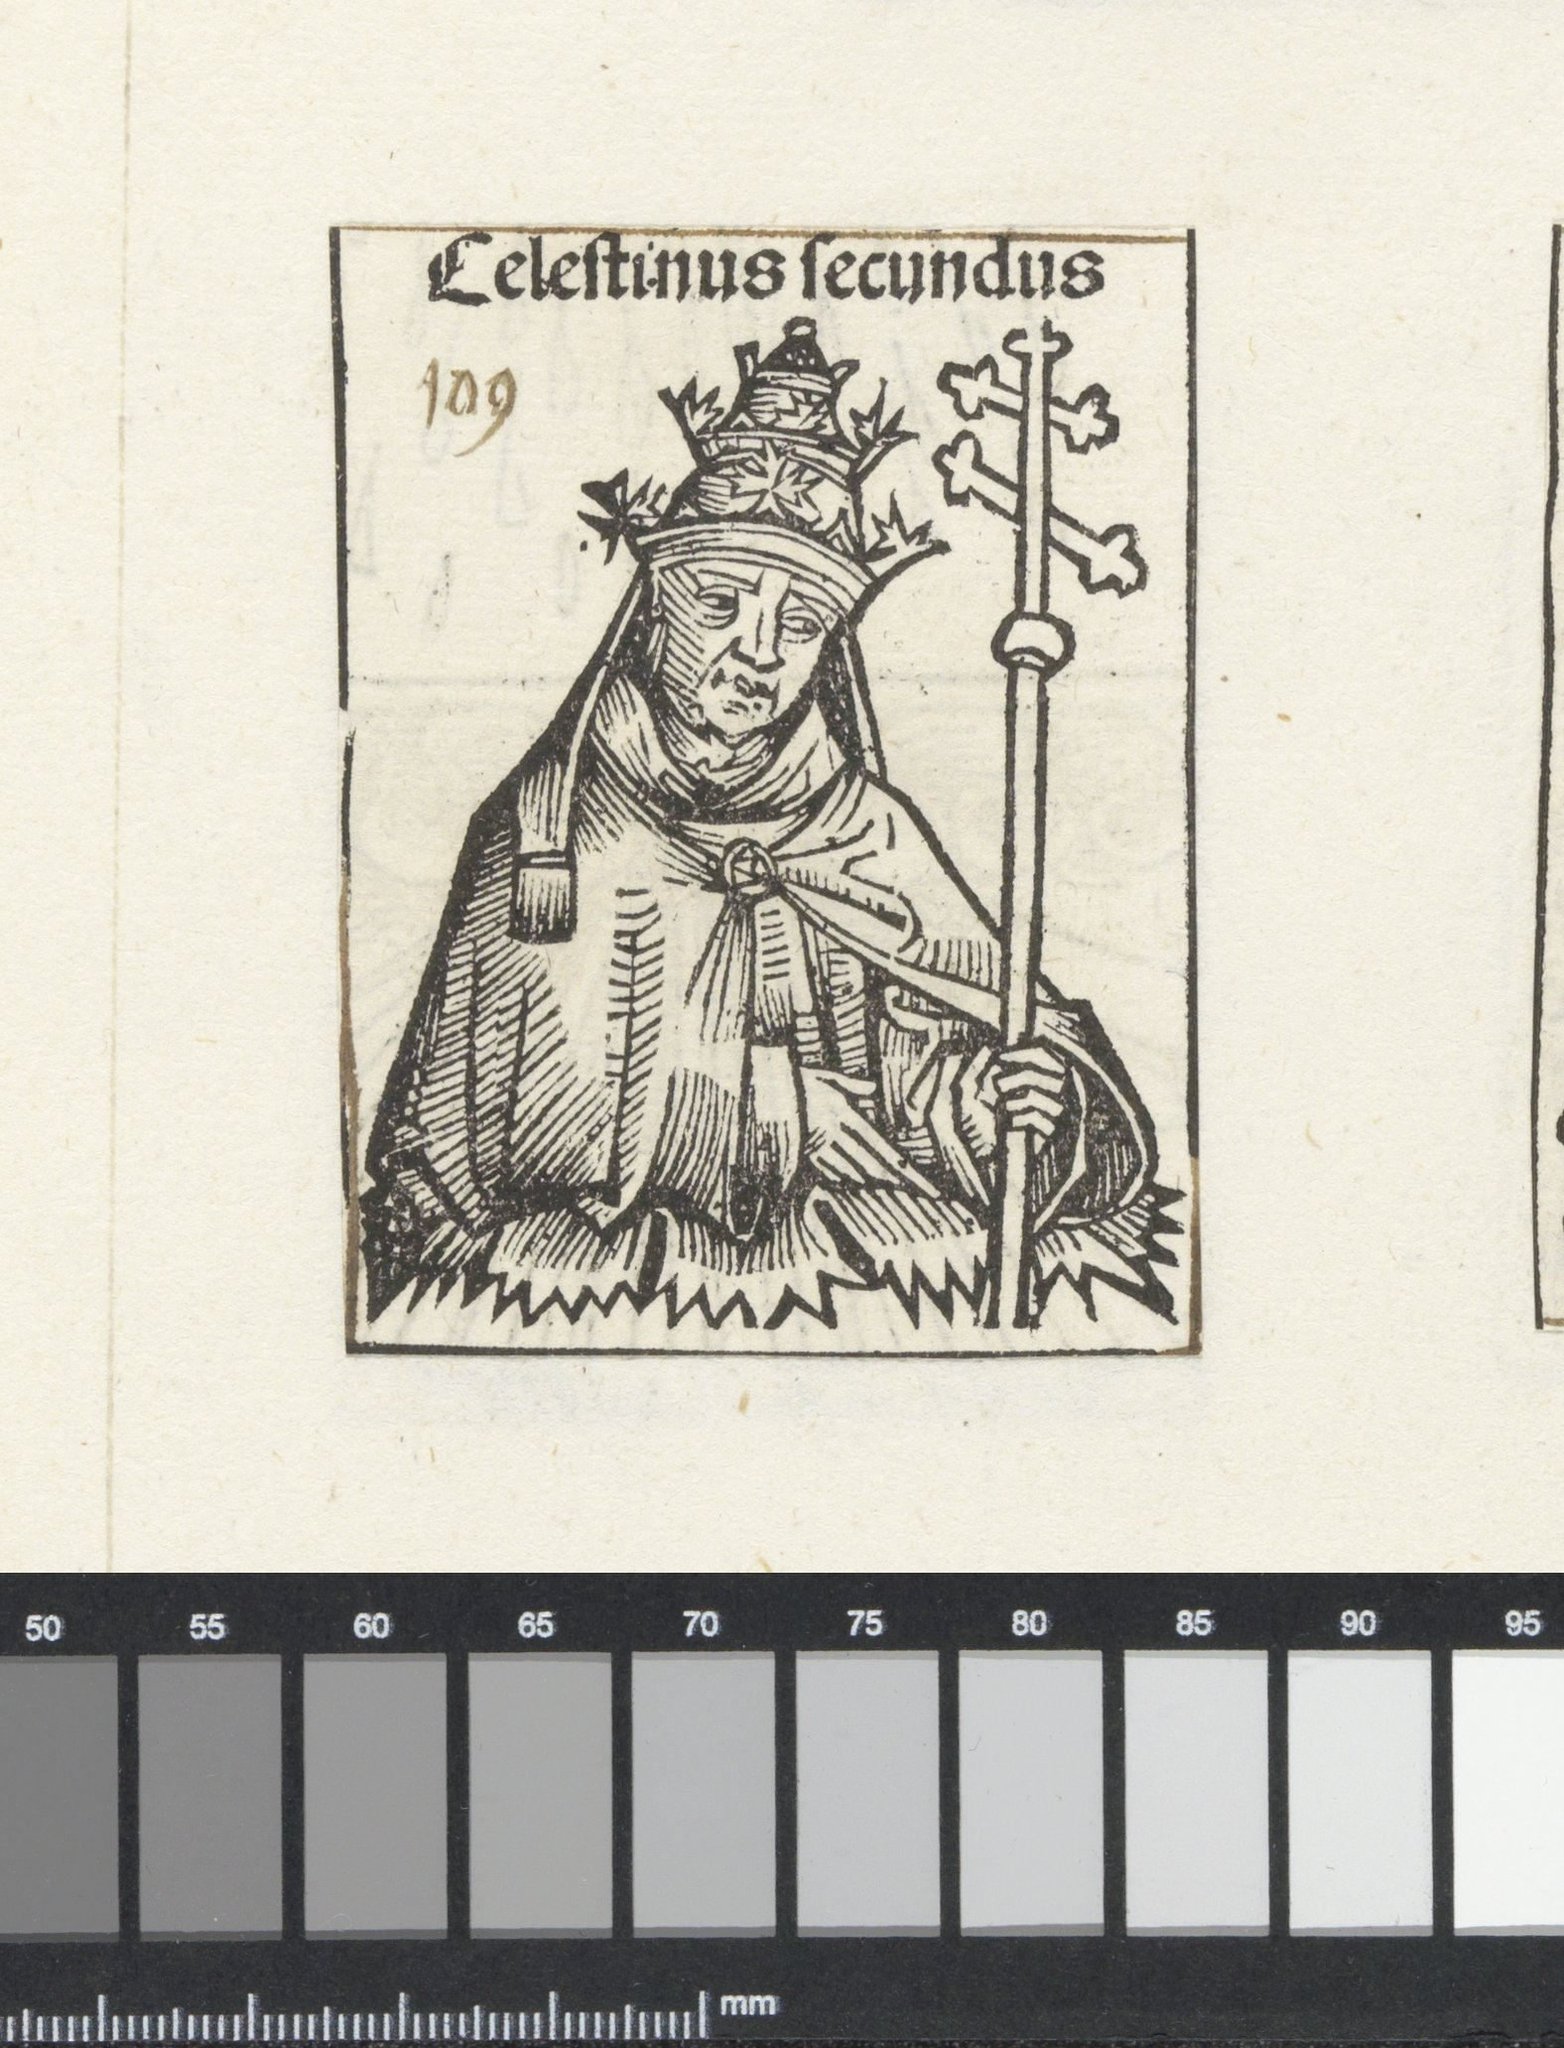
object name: print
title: Liber Chronicarum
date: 1493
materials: paper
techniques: letterpress printing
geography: nuremberg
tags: rome, pope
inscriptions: inscription: ‘109’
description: Een bloemkelk met een paus. Hij draagt een tiara en heeft een staf met een dubbel kruis in zijn handen. De voorstelling is onderdeel van de opeenvolging pausen in de Liber Chronicarum. De tekst identificeert de man als Celestinus II. De prent maakt deel uit van een album.